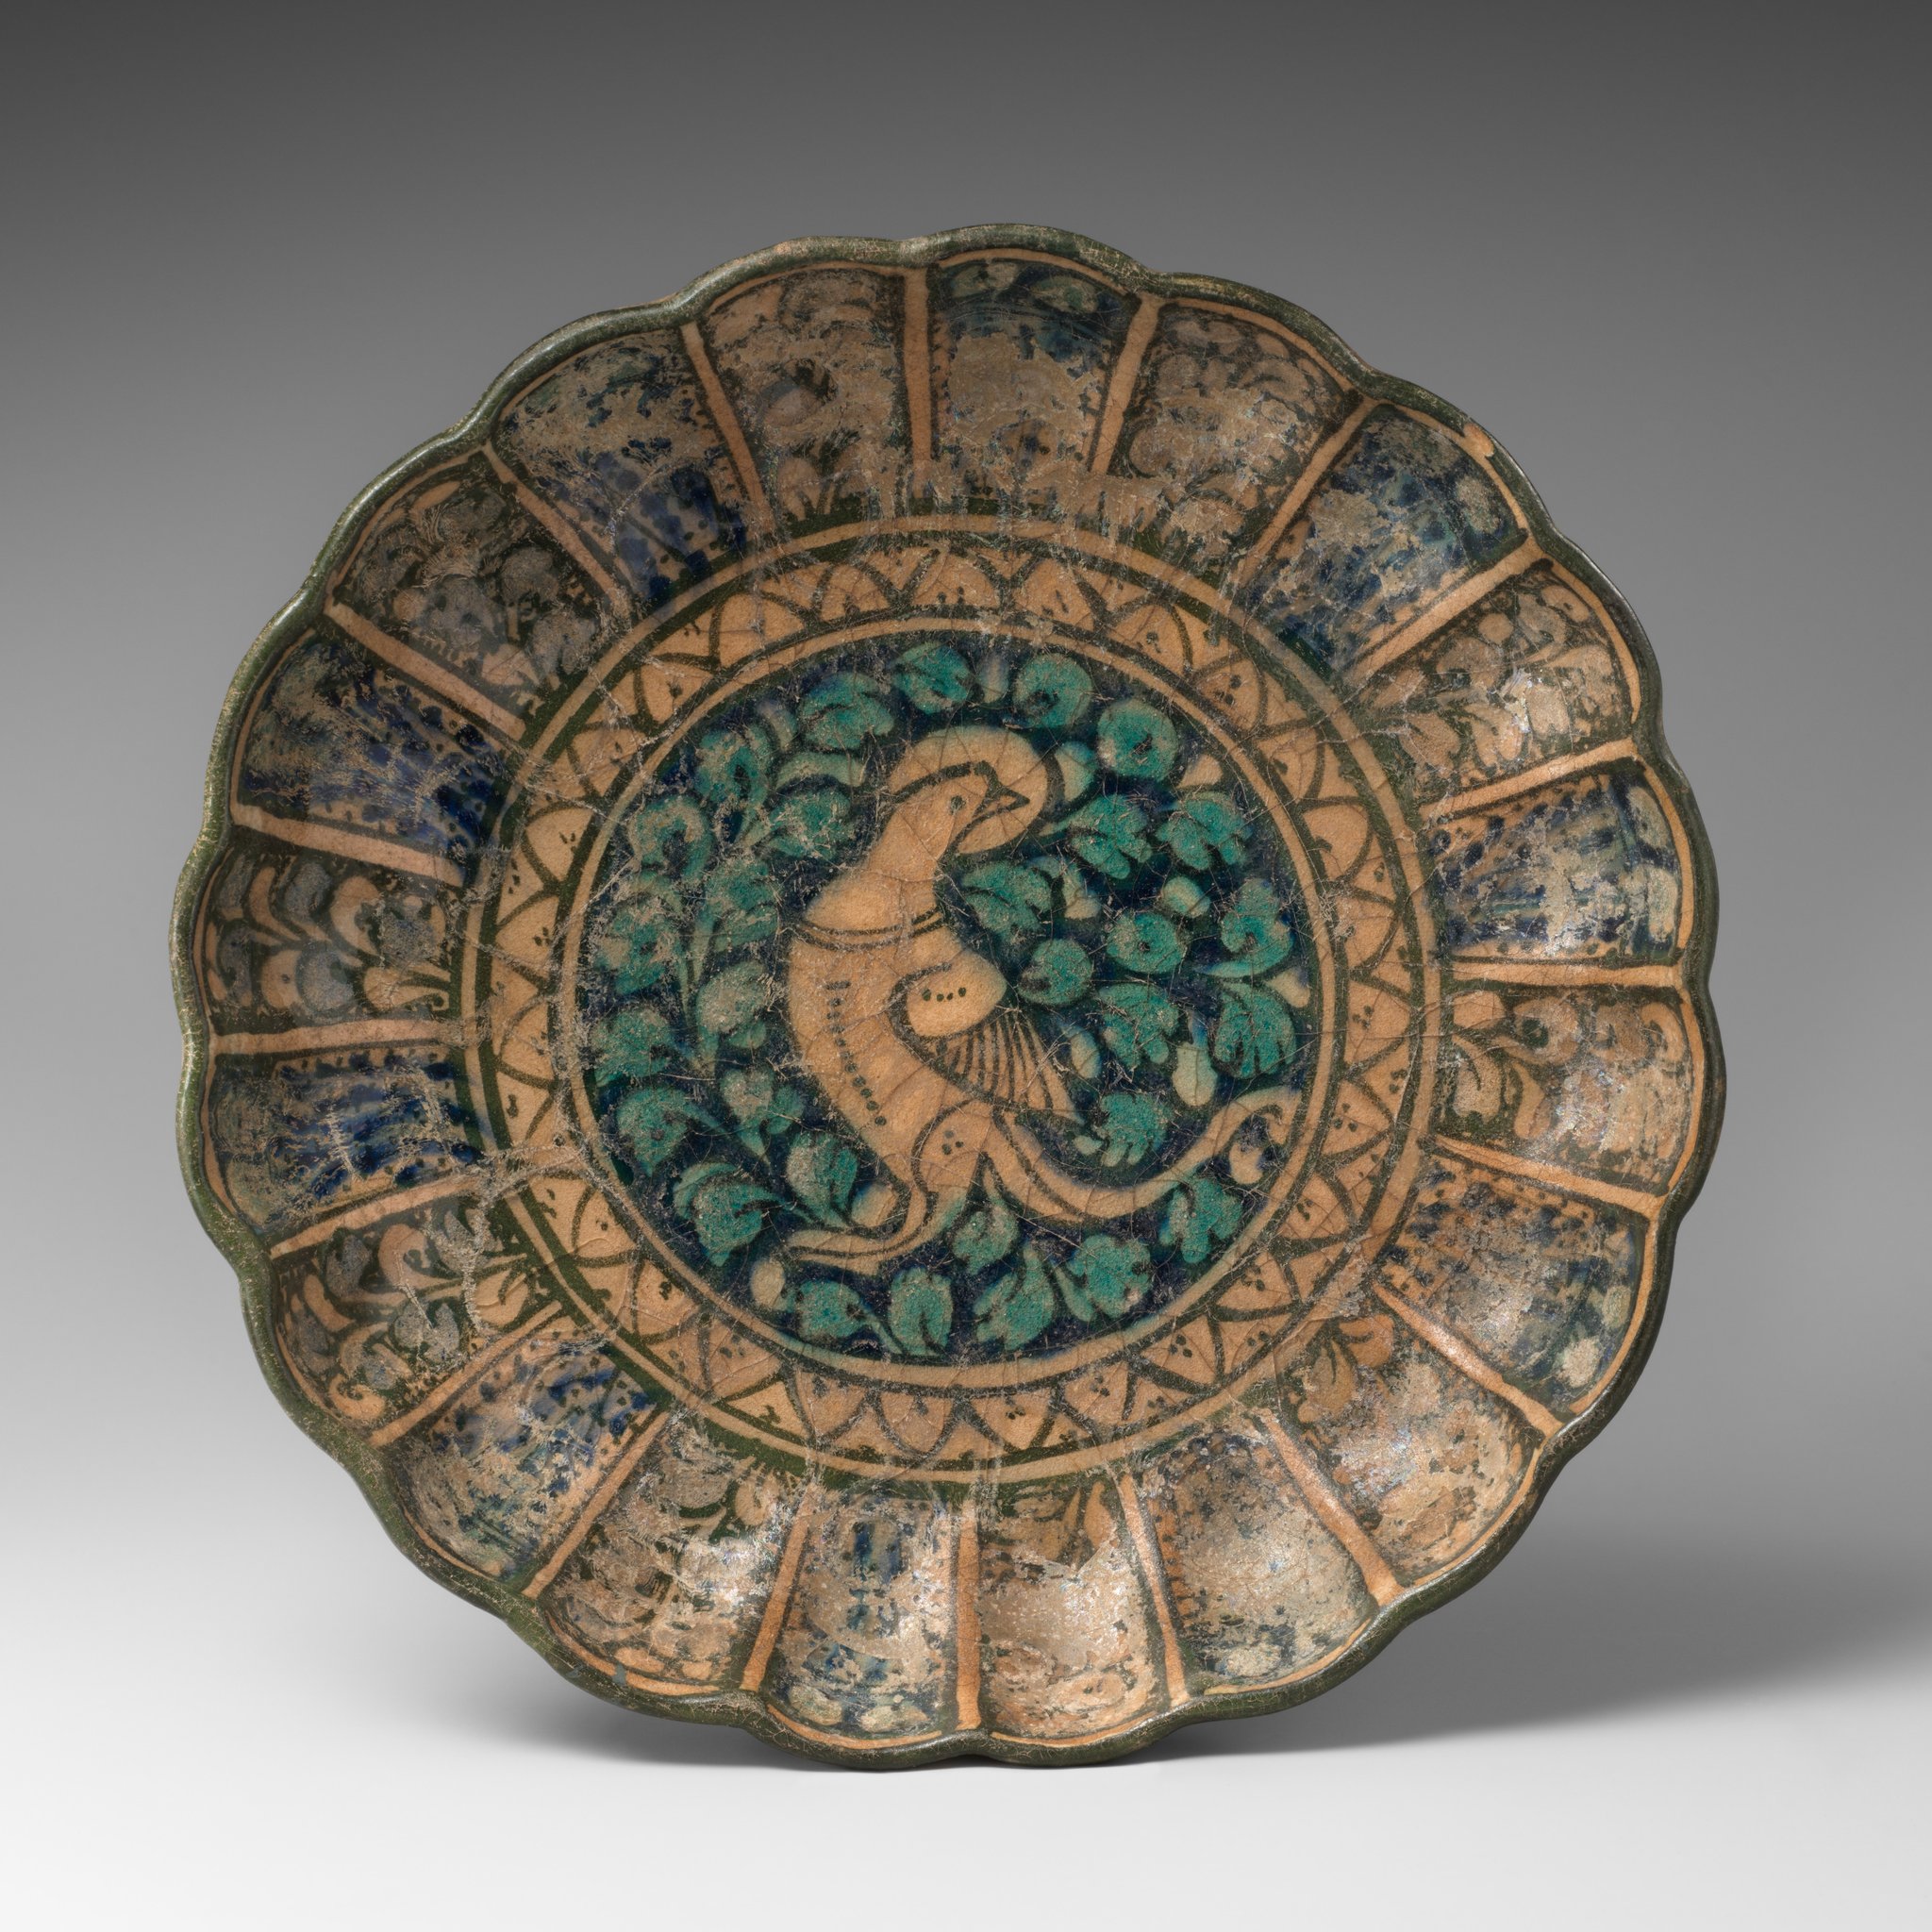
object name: dish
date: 1301-1400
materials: earthenware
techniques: painting, underglaze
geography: iran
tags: birds